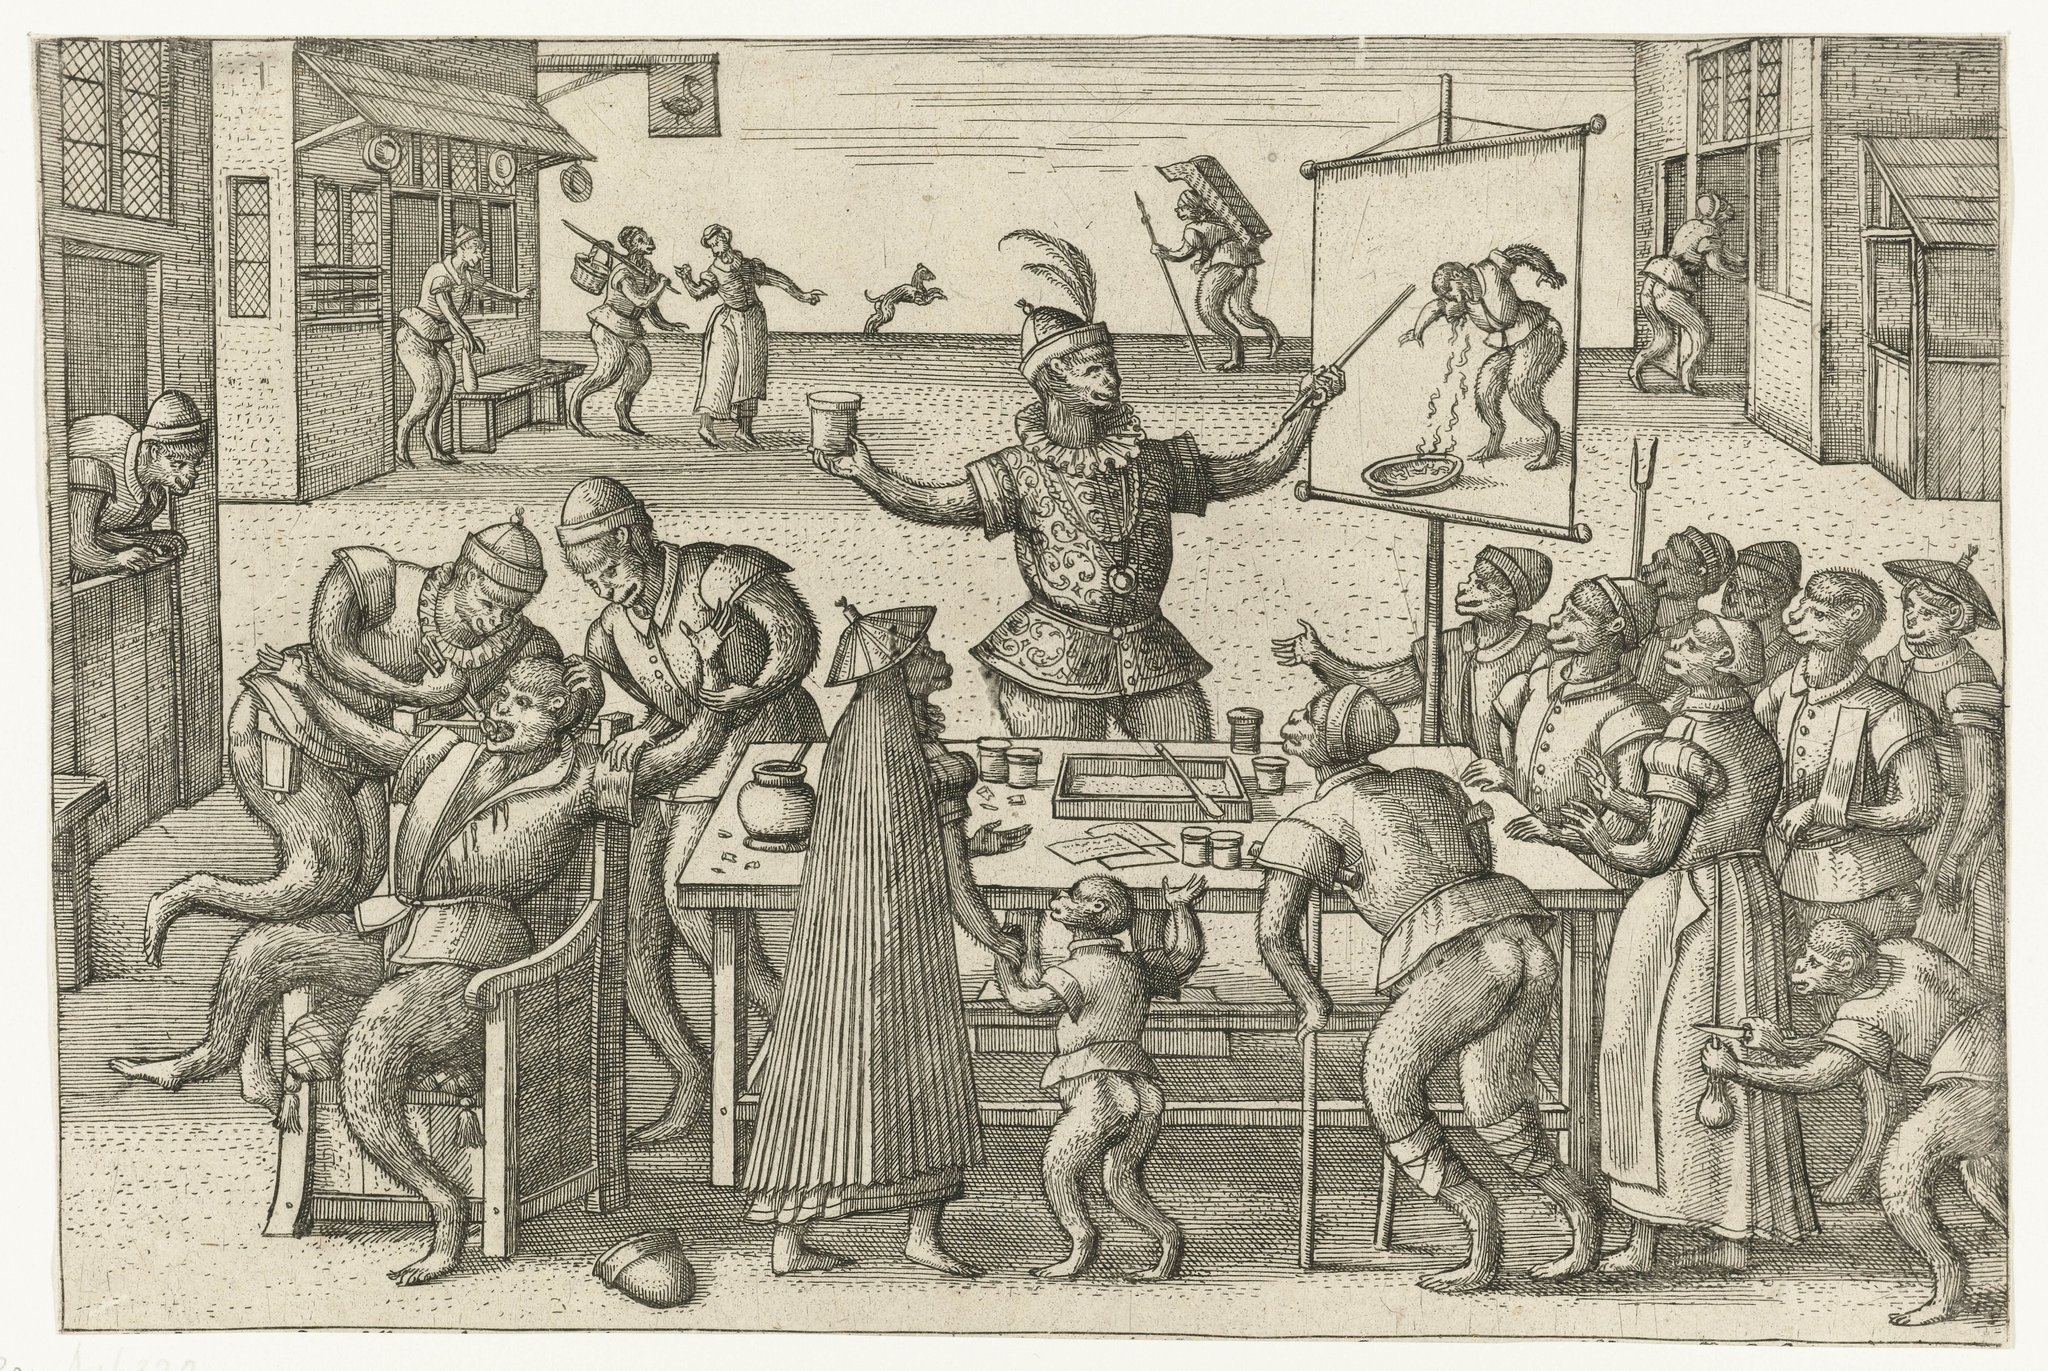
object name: print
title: Kwakzalver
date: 1545-1608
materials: paper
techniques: etching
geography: antwerp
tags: monkeys, apes, 'mundus inversus', the reversed world, the topsy-turvy world, 'le monde bestourné', quack, charlatan, mountebank, 'saltimbanco', quack extracting teeth or molars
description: Een 16de-eeuws straatbeeld met apen verkleed als mensen. Centraal op de voorgrond verkoopt een kwakzalver een middeltje tegen (of misschien wel voor) haaruitval. Zijn verkoopspraatje lokt heel wat toehoorders. Aan de rechterkant wordt een van zijn potentiële klanten berooft door een beurzensnijder. Aan de linkerkrant verwijderen twee chirurgijnen een tand van een aap. Andere reizende venters bevolken de achtergrond van de prent.